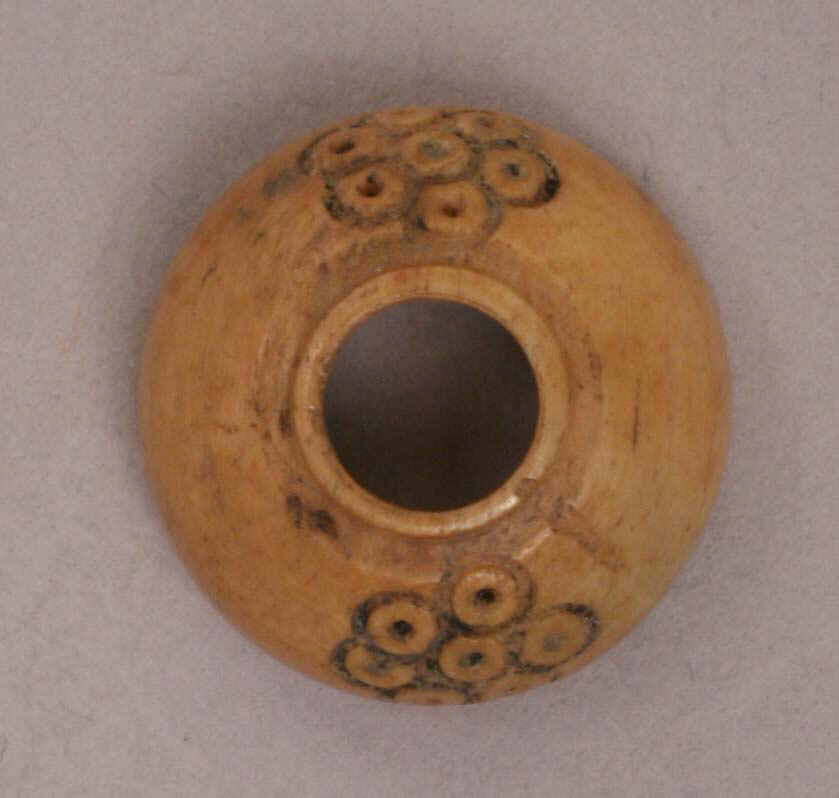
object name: button or bead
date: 801-1000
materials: bone, paint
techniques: incising, inlay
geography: iran